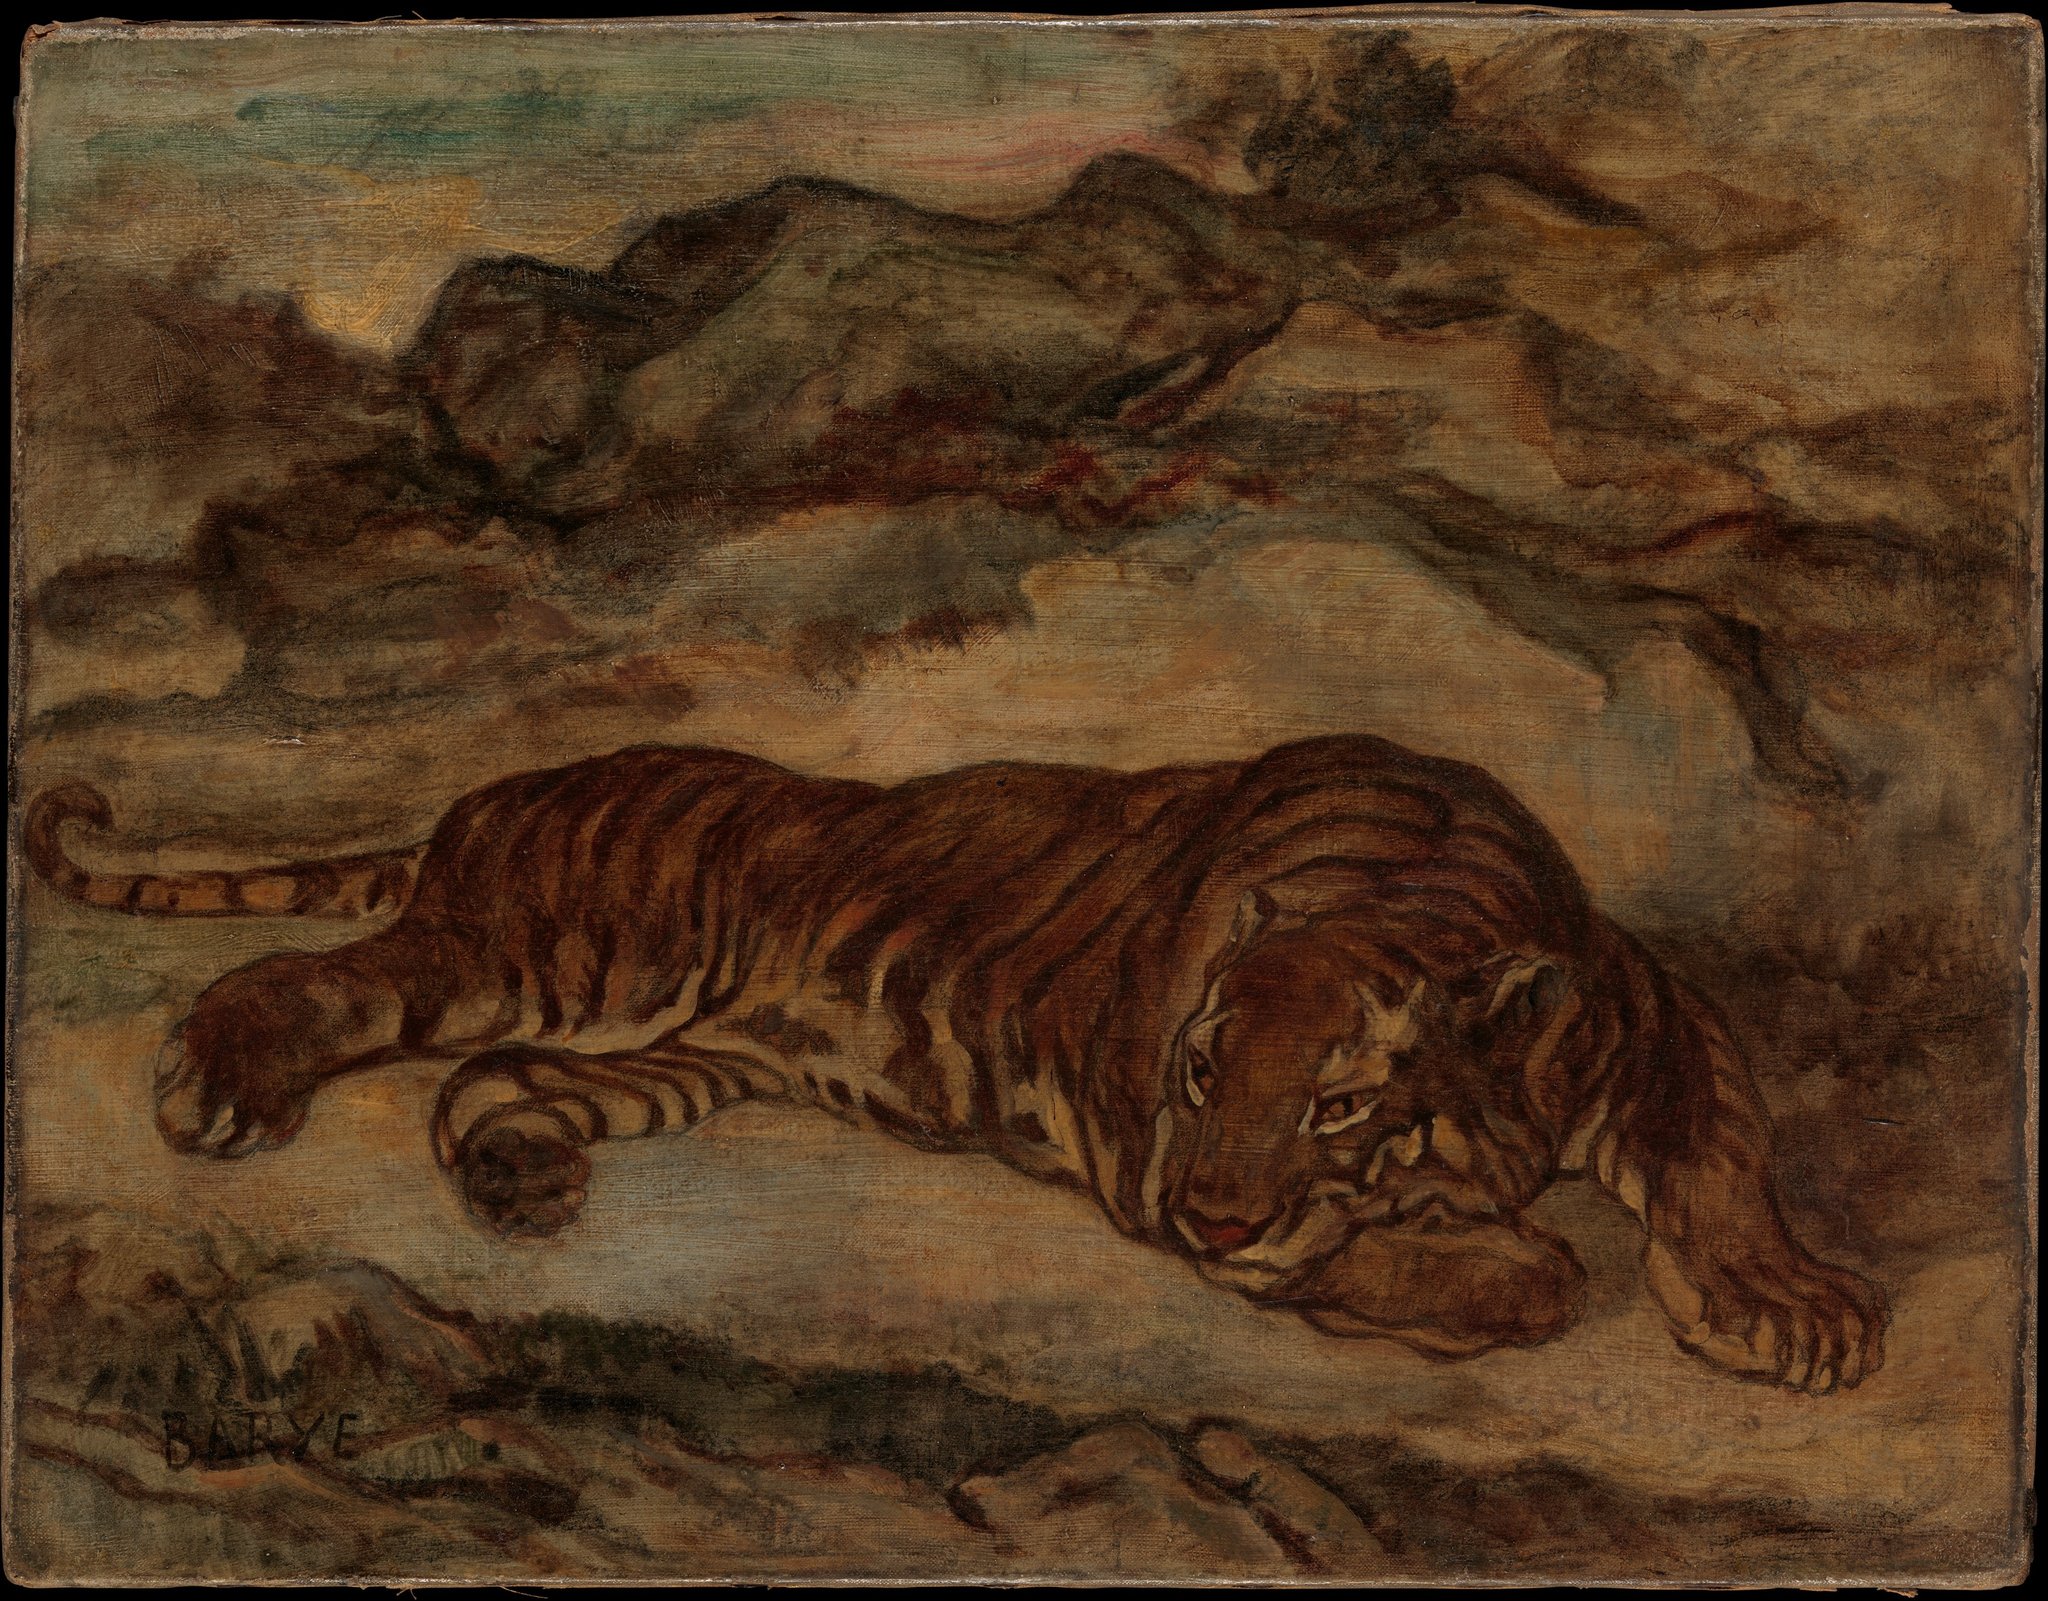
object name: painting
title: Tiger in Repose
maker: antoine-louis barye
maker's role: artist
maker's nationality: french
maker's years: 1795-1875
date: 1850-1865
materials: canvas, oil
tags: tigers